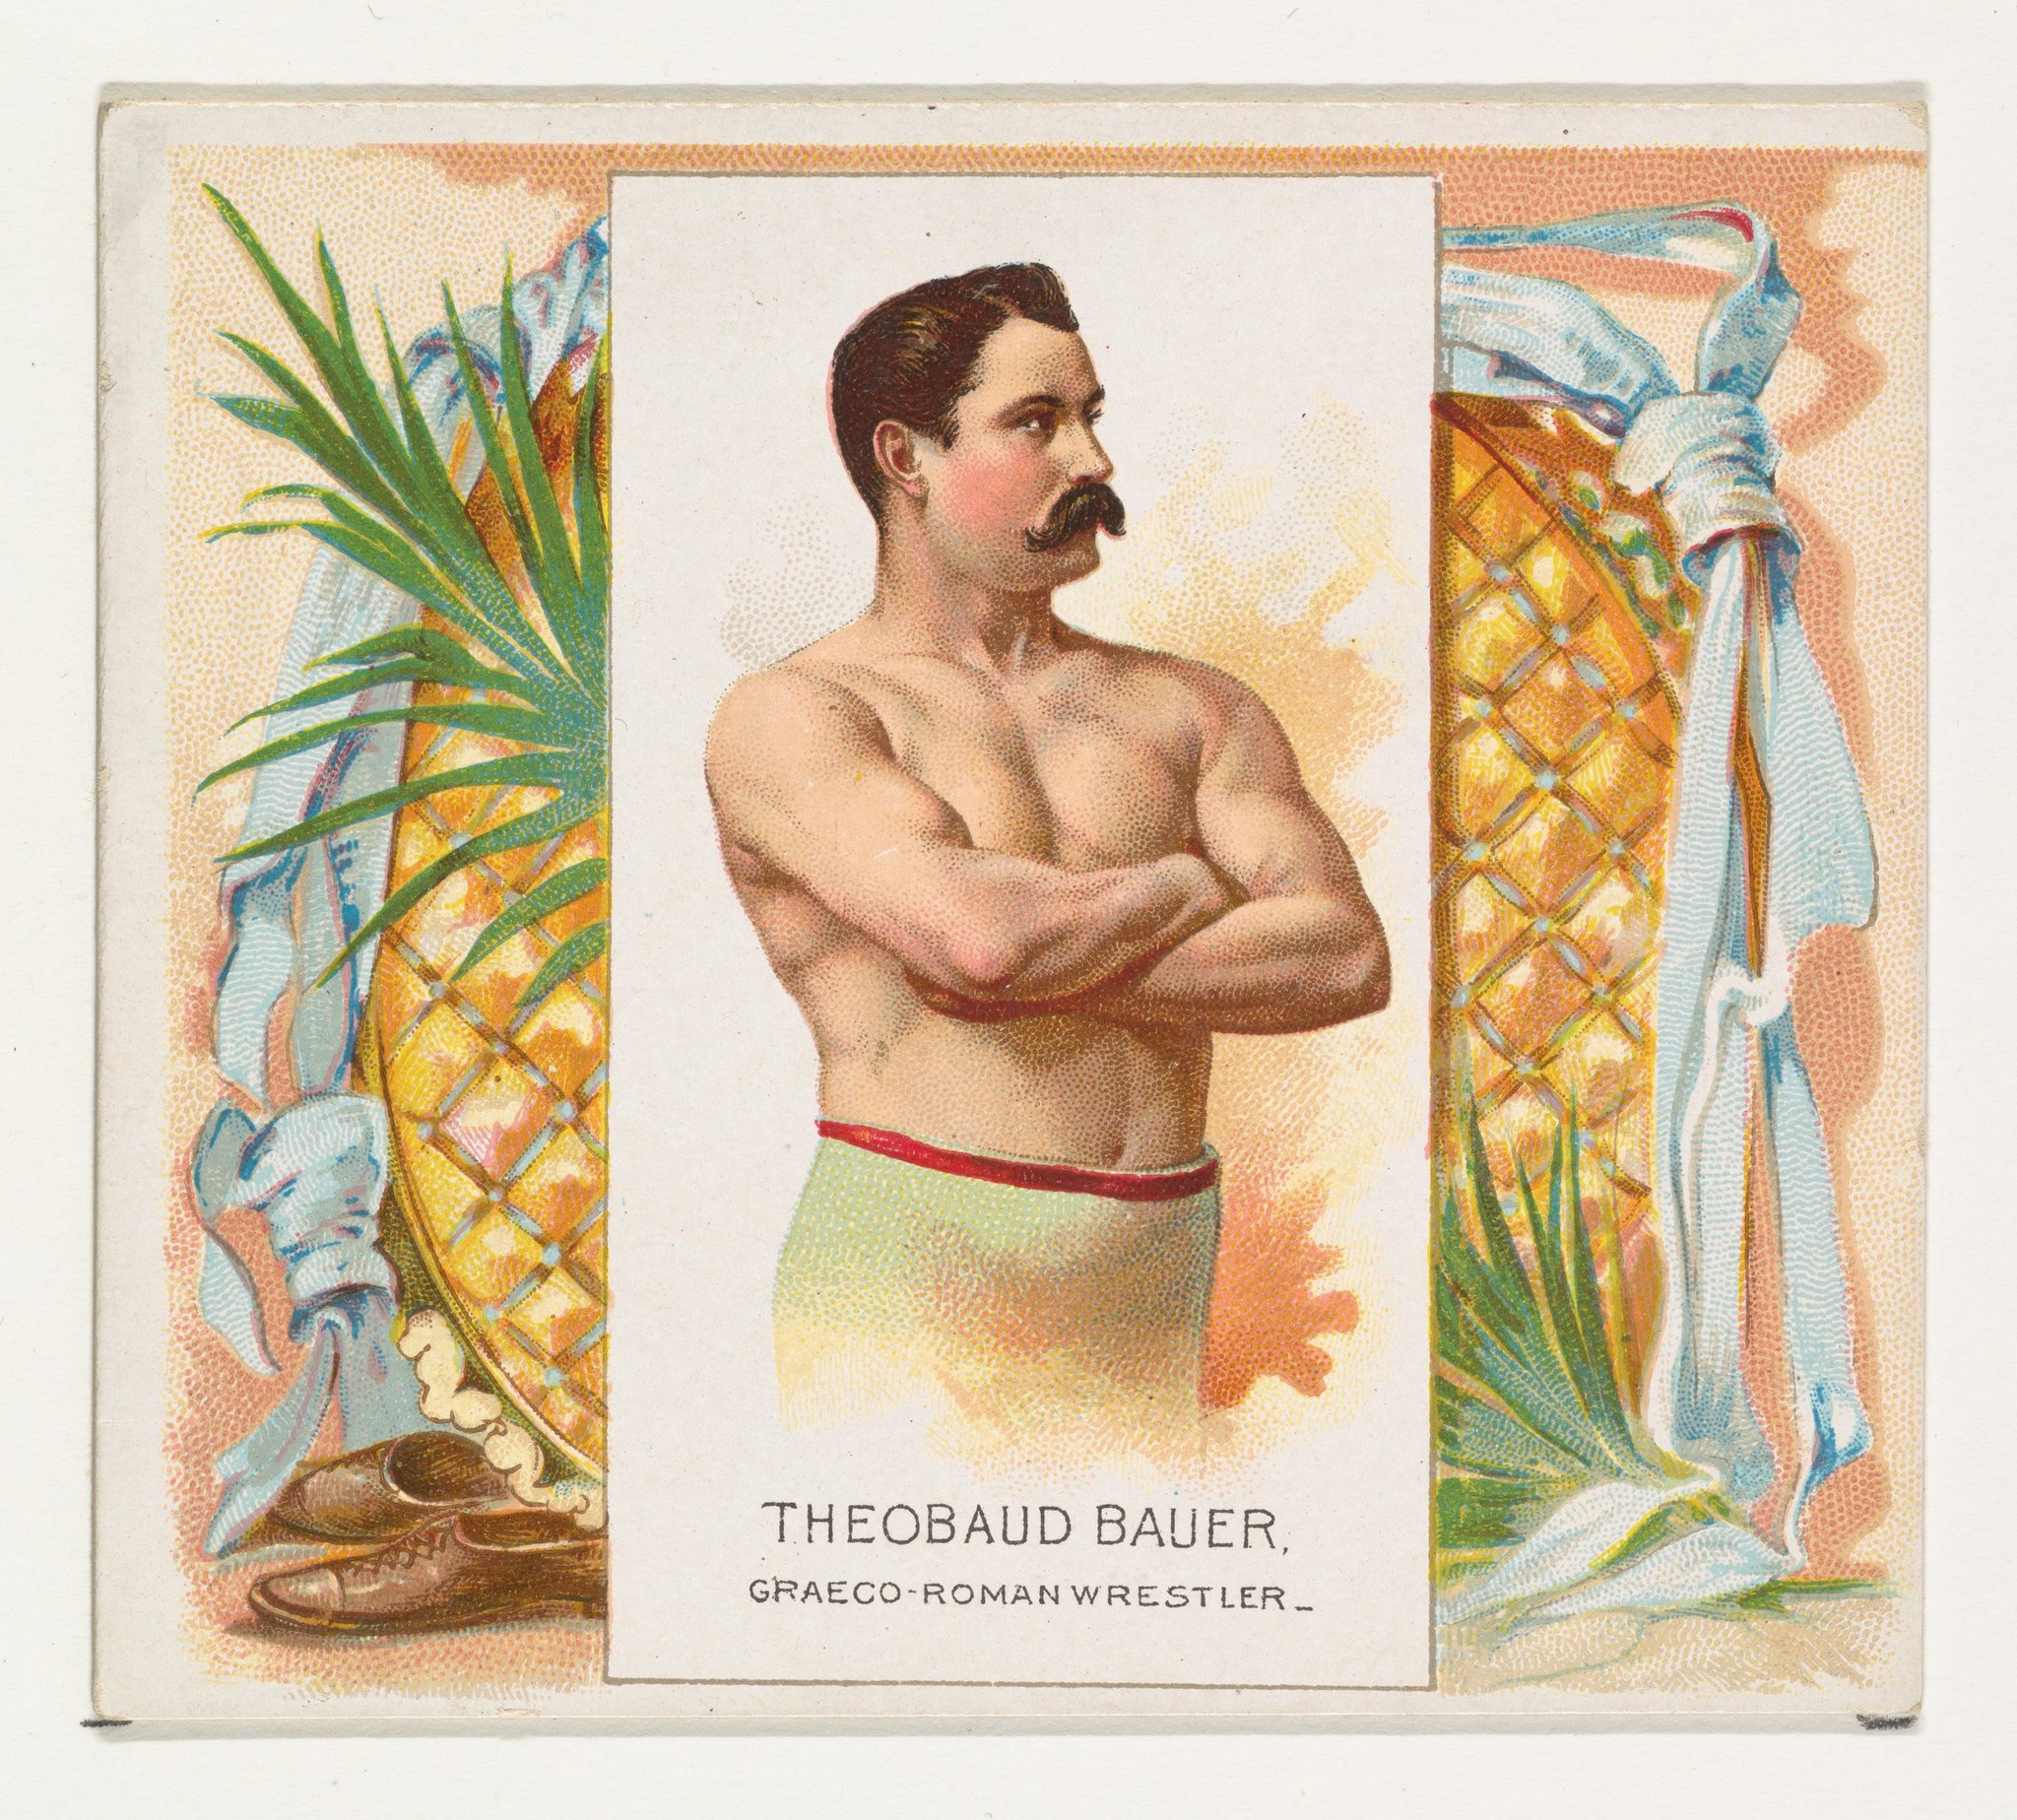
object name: print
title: Theobaud Bauer, Graeco-Roman Wrestler, from World's Champions, Second Series (N43) for Allen & Ginter Cigarettes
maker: allen & ginter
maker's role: publisher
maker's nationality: american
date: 1888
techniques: lithography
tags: men,profiles,athletes